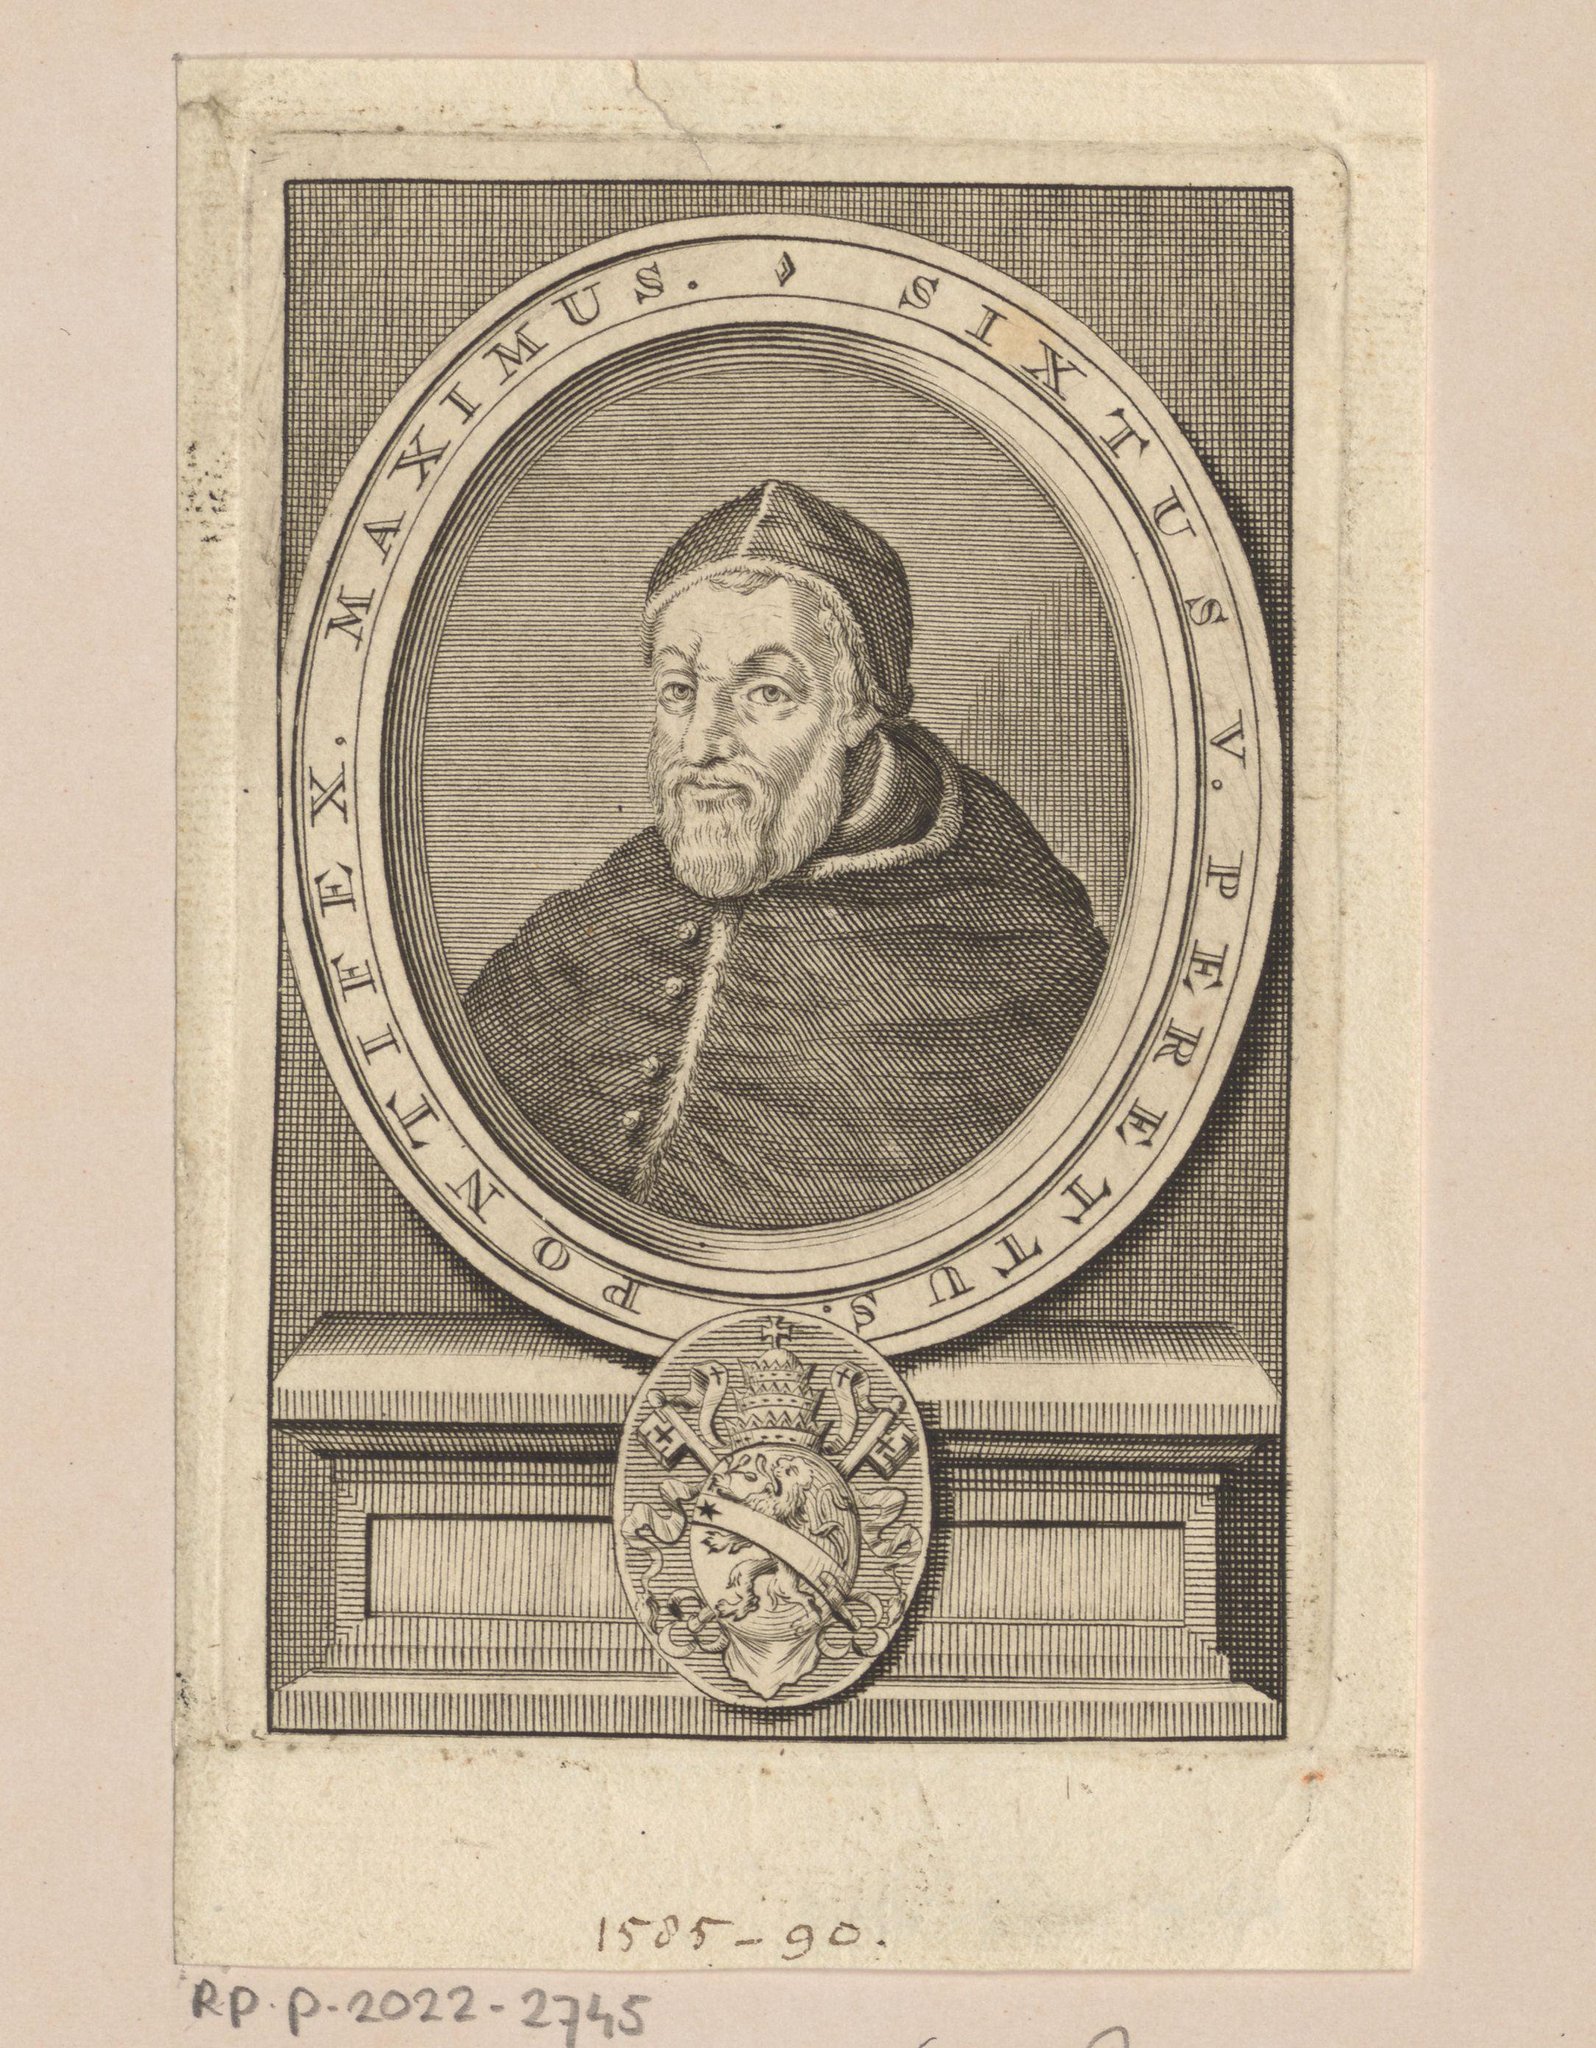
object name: print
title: Portret van Sixtus V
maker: Anonymous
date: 1585-1699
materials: paper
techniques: engraving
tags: rome, sixtus v, historical persons, pope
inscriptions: inscription: ‘Het Tronietje een Wijnigje / te accomoderen’, inscription: ‘1585-90’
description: Met tekst in het Latijn rondom het portret.